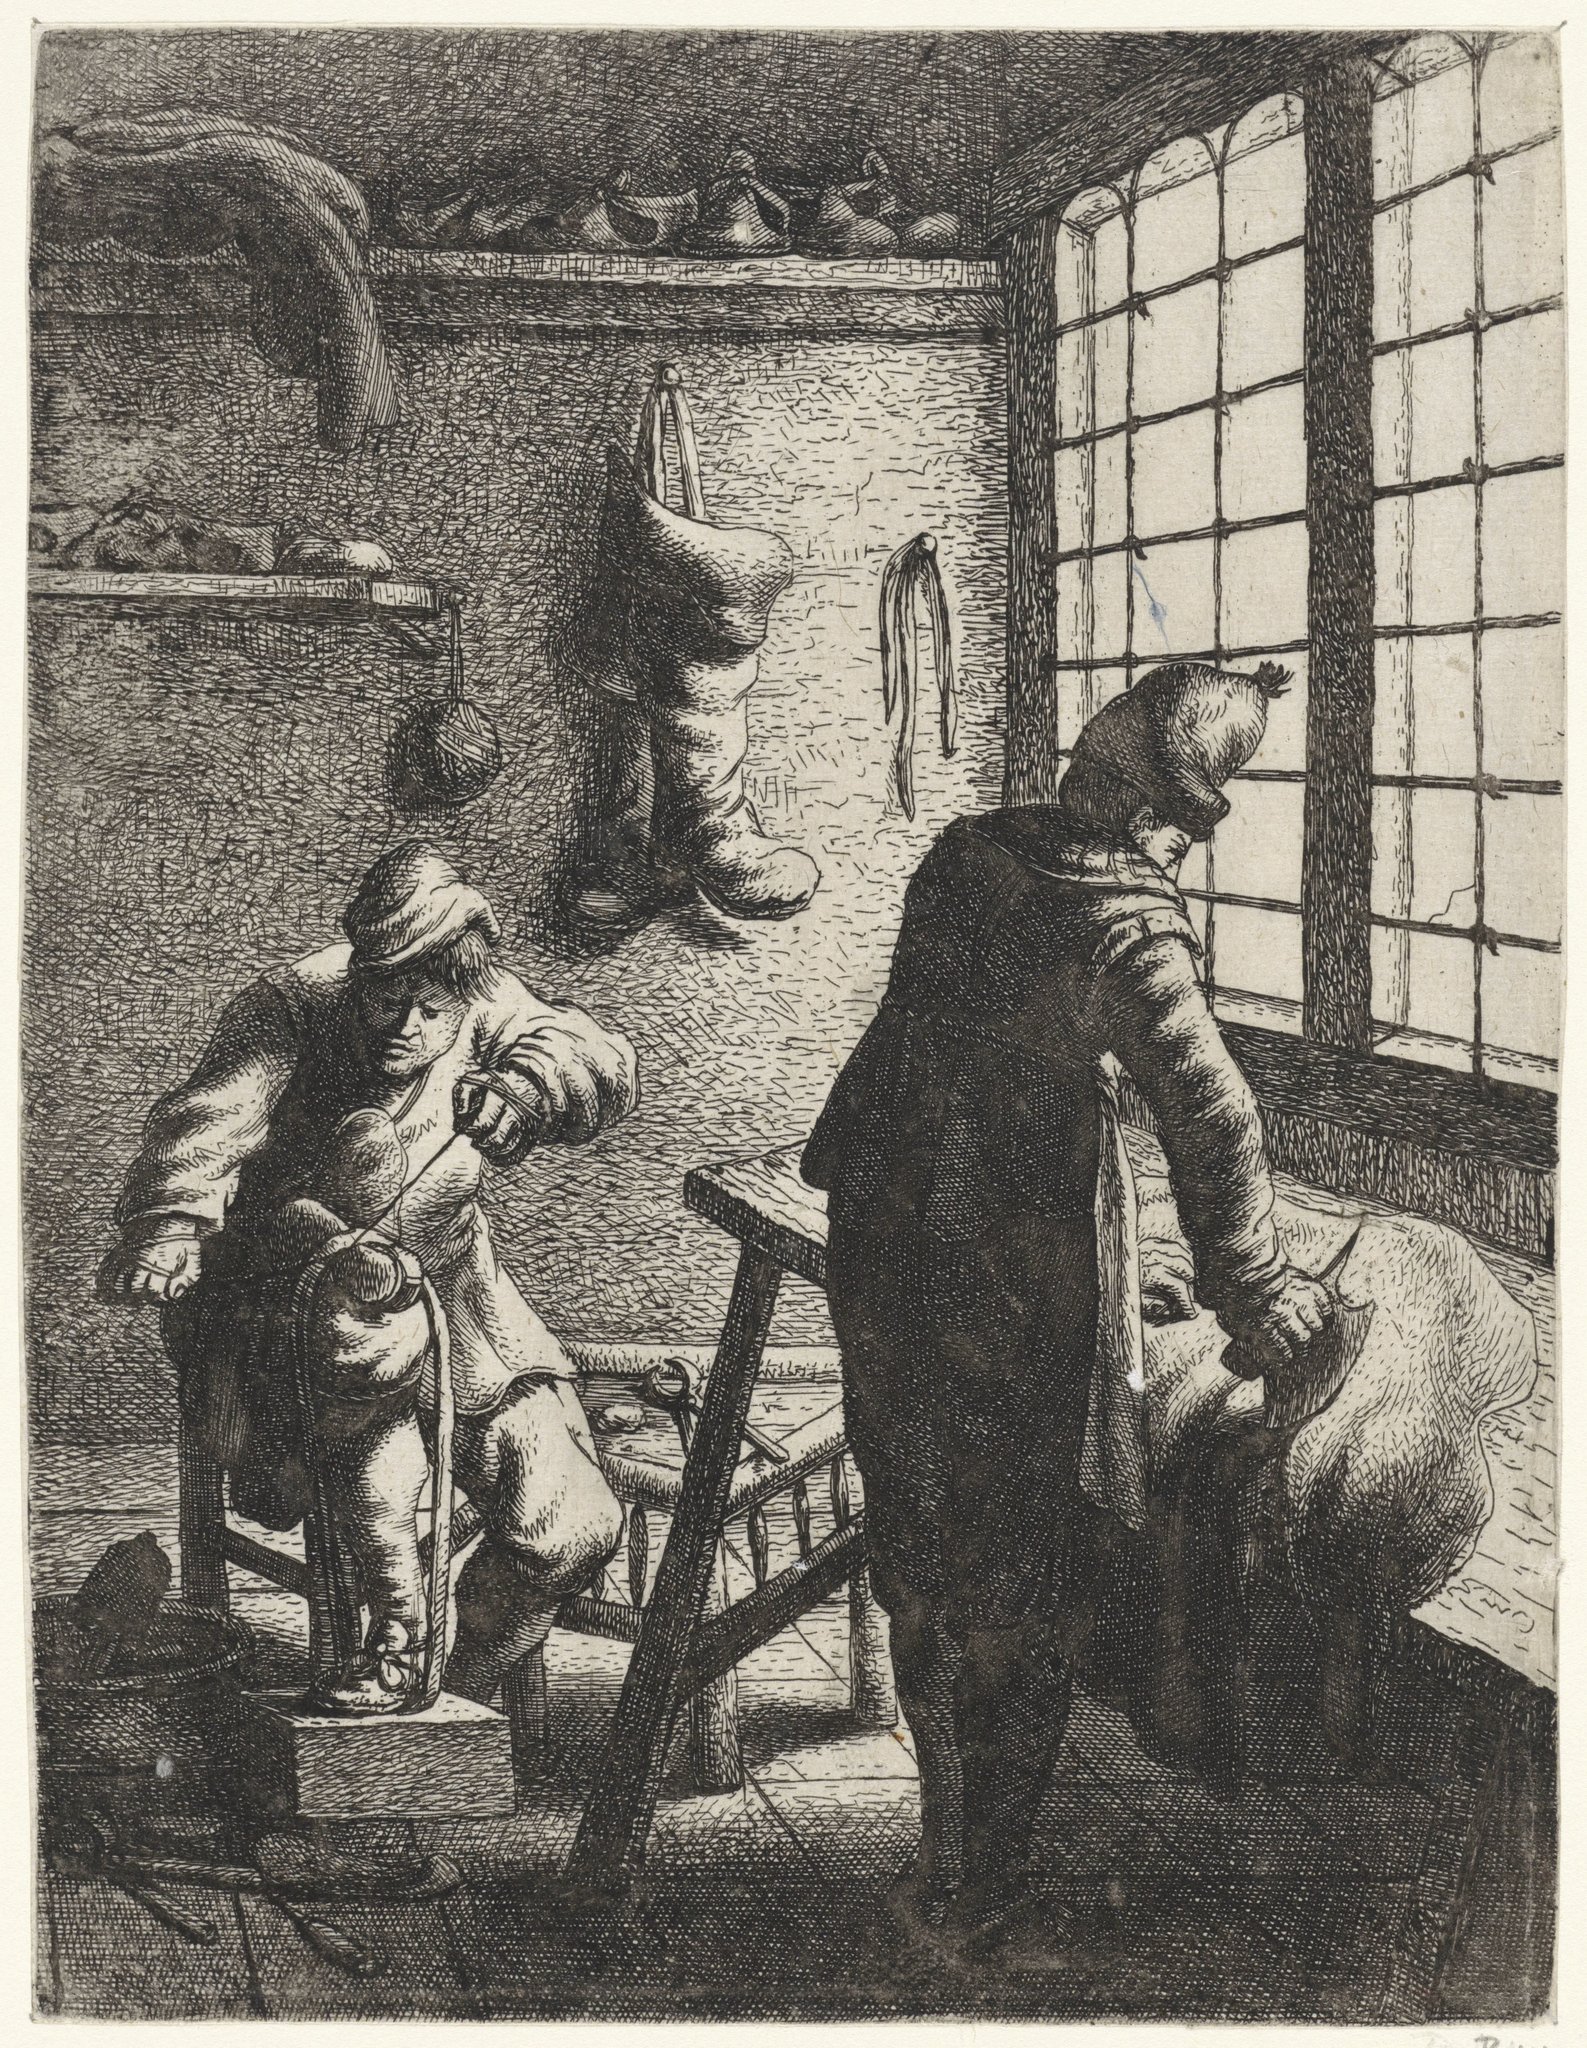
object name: print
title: Schoenmakers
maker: jan gillisz. van vliet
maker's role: draughtsman, painter, print maker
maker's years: 1600-1668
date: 1635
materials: paper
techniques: etching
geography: leiden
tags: manufacture of leather, shoe-maker, cobbler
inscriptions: collector's mark: Lugt 240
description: Een man bewerkt leer, staand achter een tafel en een zittende man maakt een schoen in een schoenmakerij.